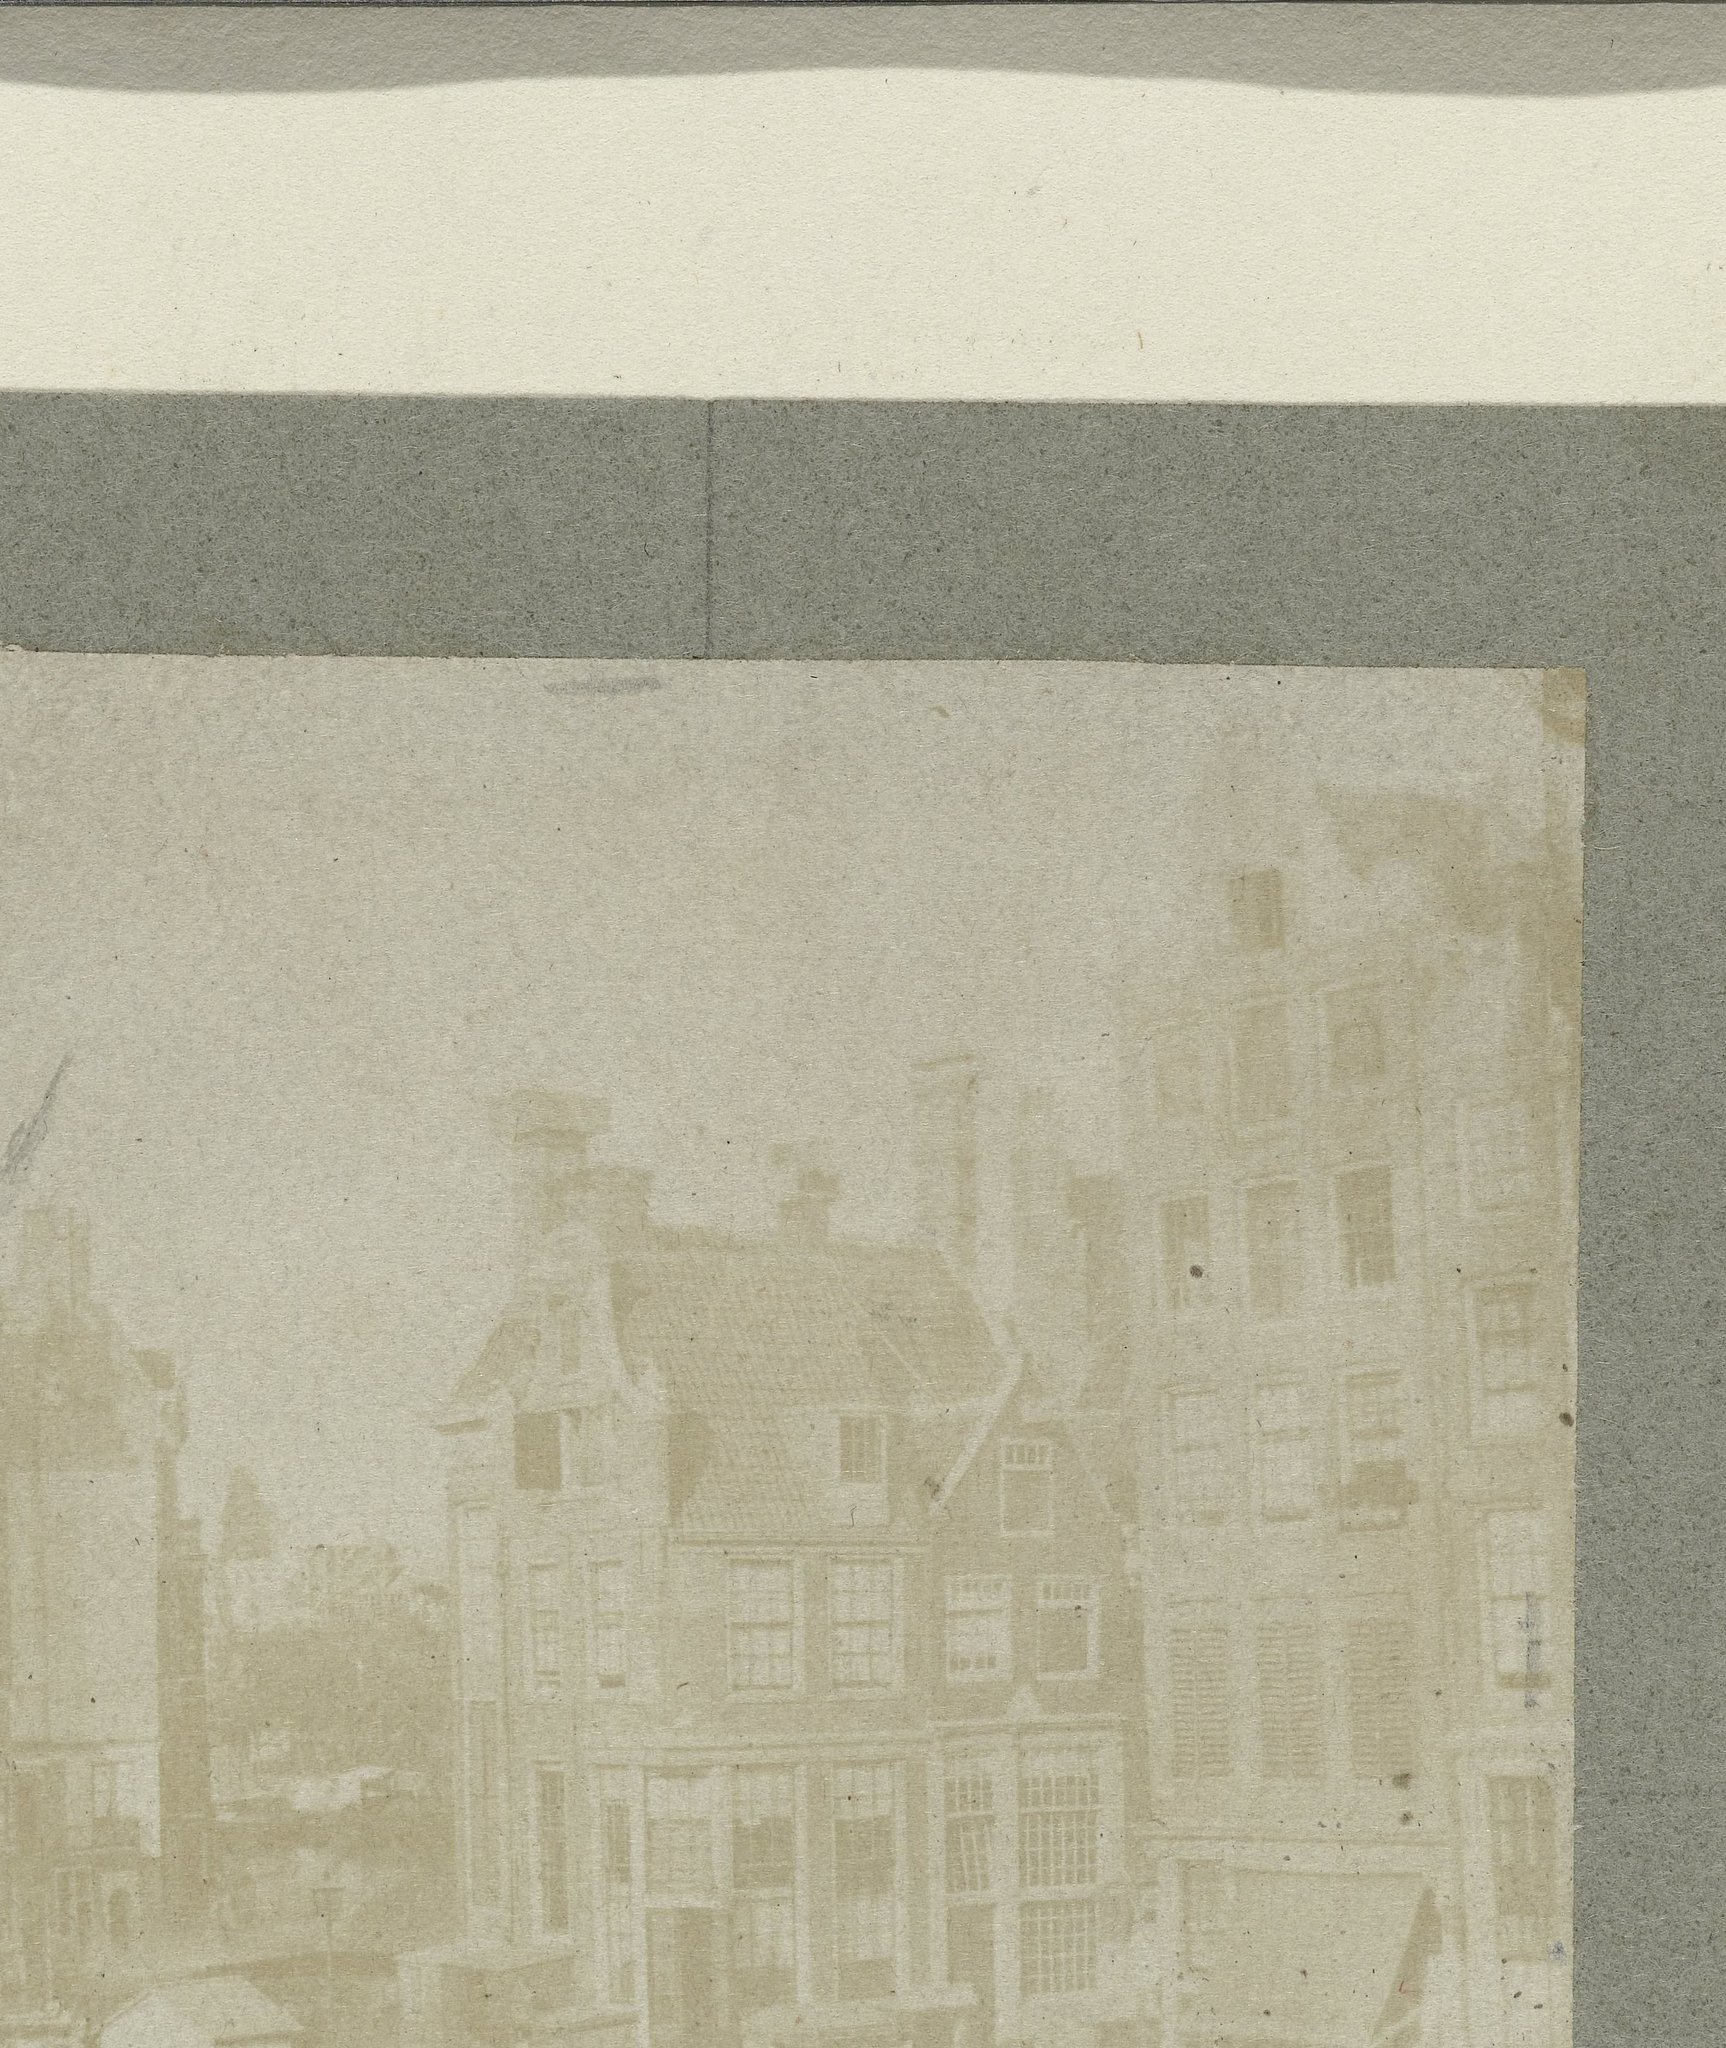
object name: photograph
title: Gezicht vanuit het huis van de fotograaf richting logement Rondeel, Amsterdam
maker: eduard isaac asser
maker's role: amateurfotograaf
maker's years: 1809-1894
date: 1845-1846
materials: cardboard, paper, photographic support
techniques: salted paper print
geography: amsterdam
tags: hotel het rondeel, reguliersbreestraat, kloveniersburgwal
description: Uitzicht uit het huis van de fotograaf, Singel 548, naar de ingang van de Reguliersbreestraat met geheel rechts het huis nummer 2 en daar tegenover de nummers 3 en 1. Uiterst links is een gedeelte te zien van de achterzijde van de huizen in de Nieuwe Doelenstraat.